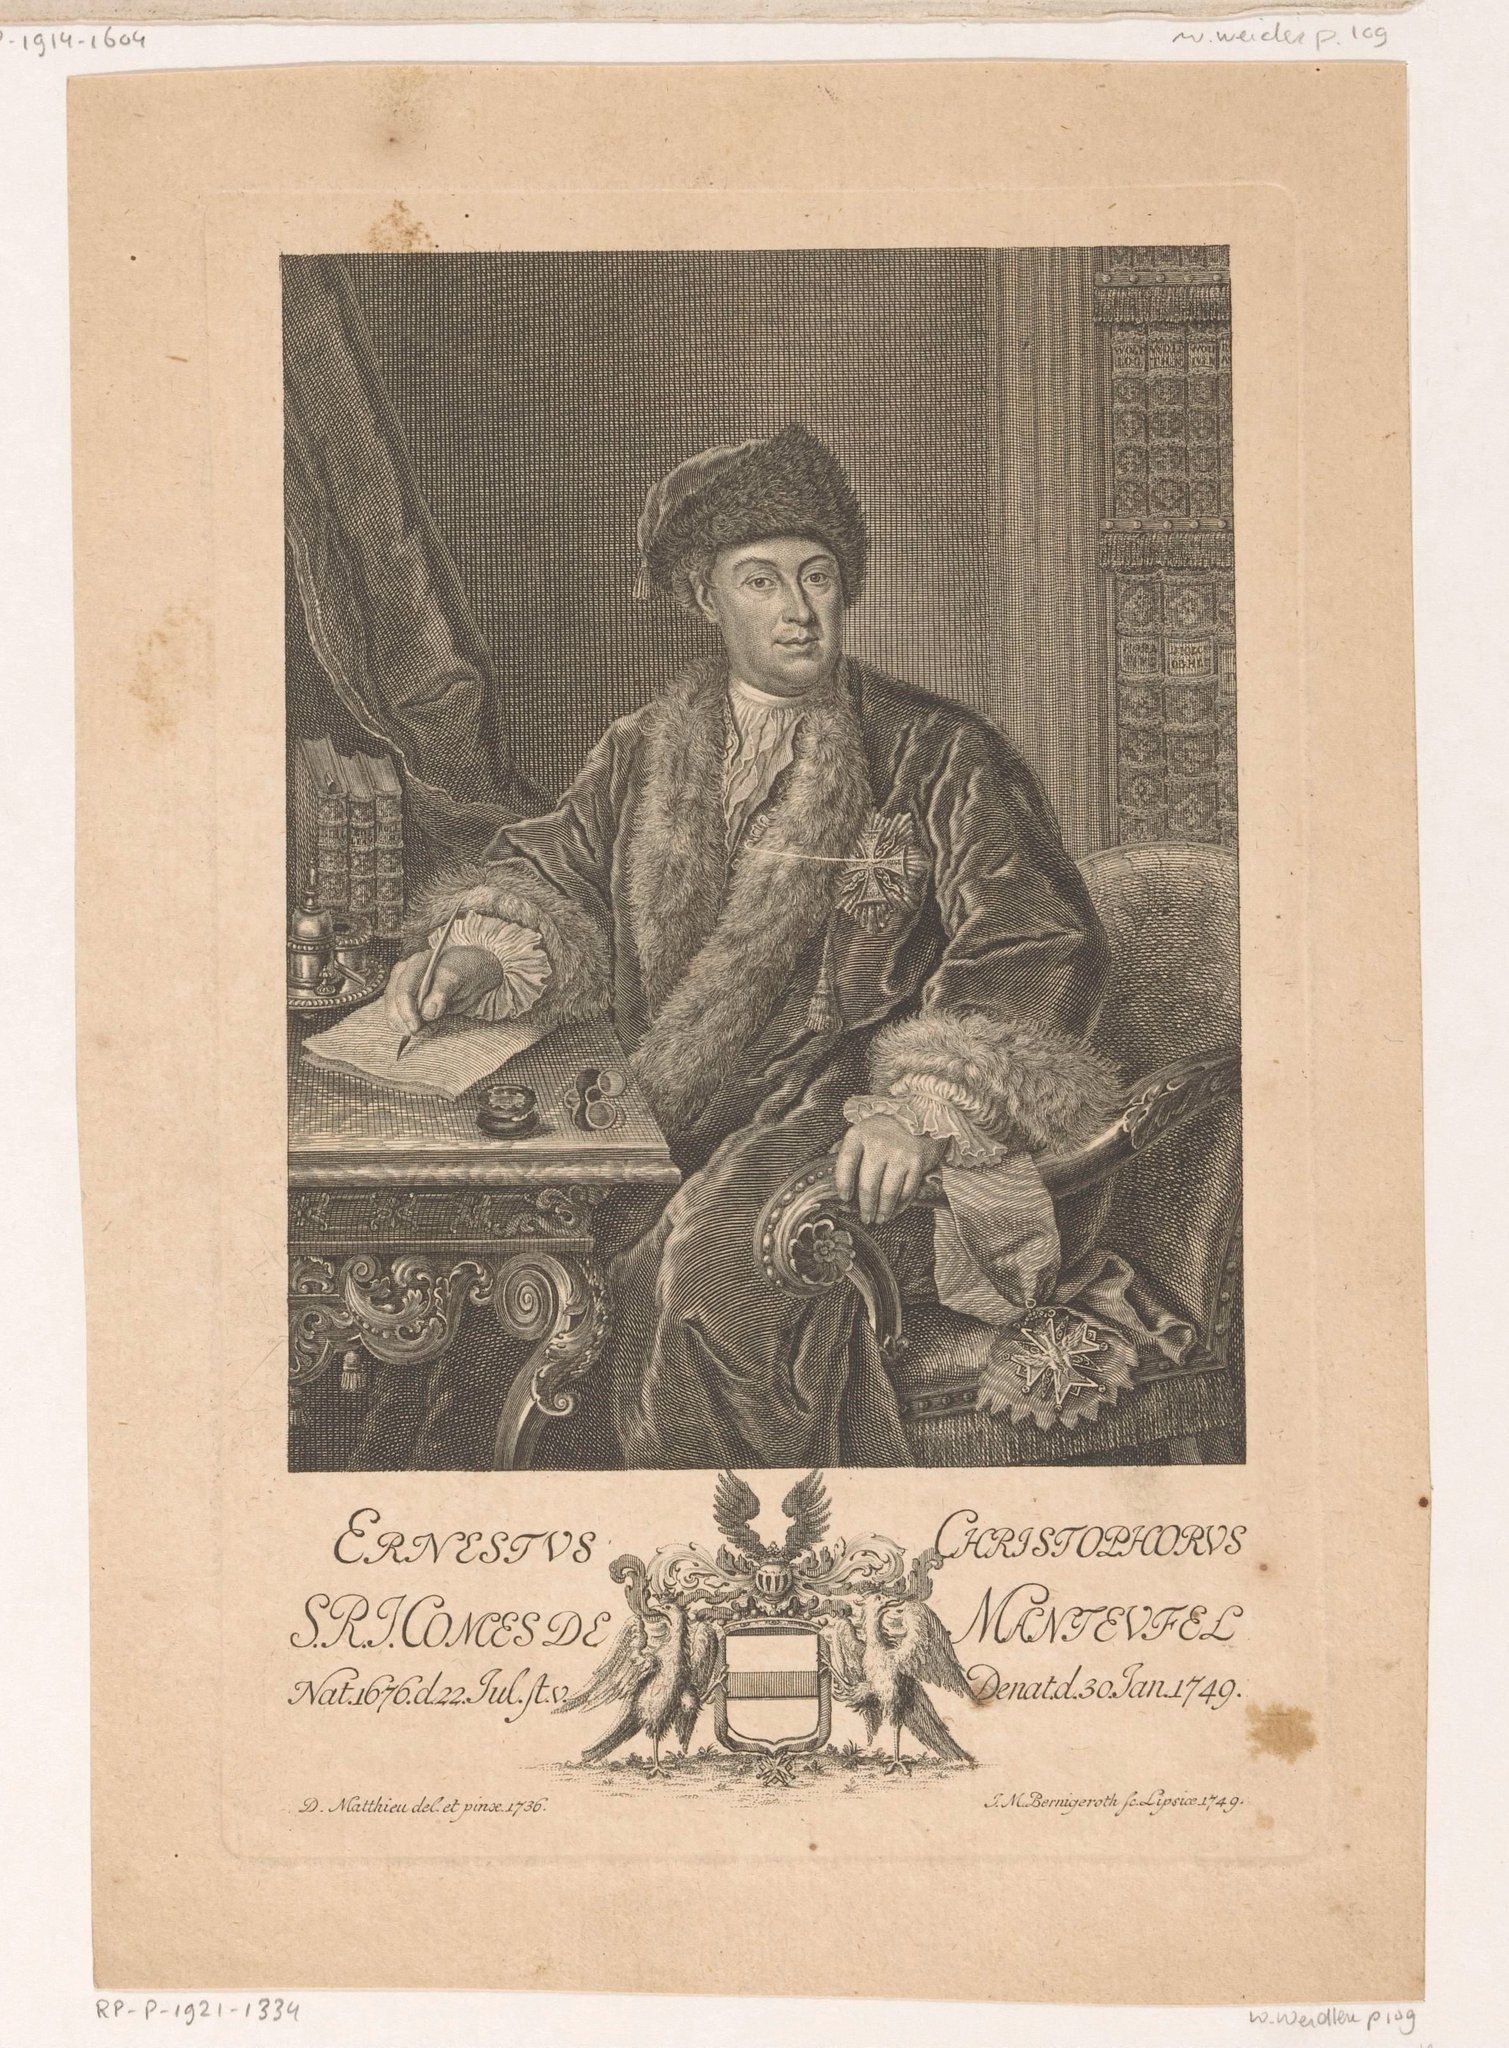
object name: print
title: Portret van Ernst Christoph, Reichsgraf von Manteuffel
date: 1749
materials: paper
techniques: engraving, etching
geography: leipzig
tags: eyeglasses, spectacles, handwriting, writing as activity, head-gear: hat (+ fur used for clothes), bookshelves, knighthood order, coat (+ fur used for clothes), historical persons, armorial bearing, heraldry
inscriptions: collector's mark: Lugt 2233